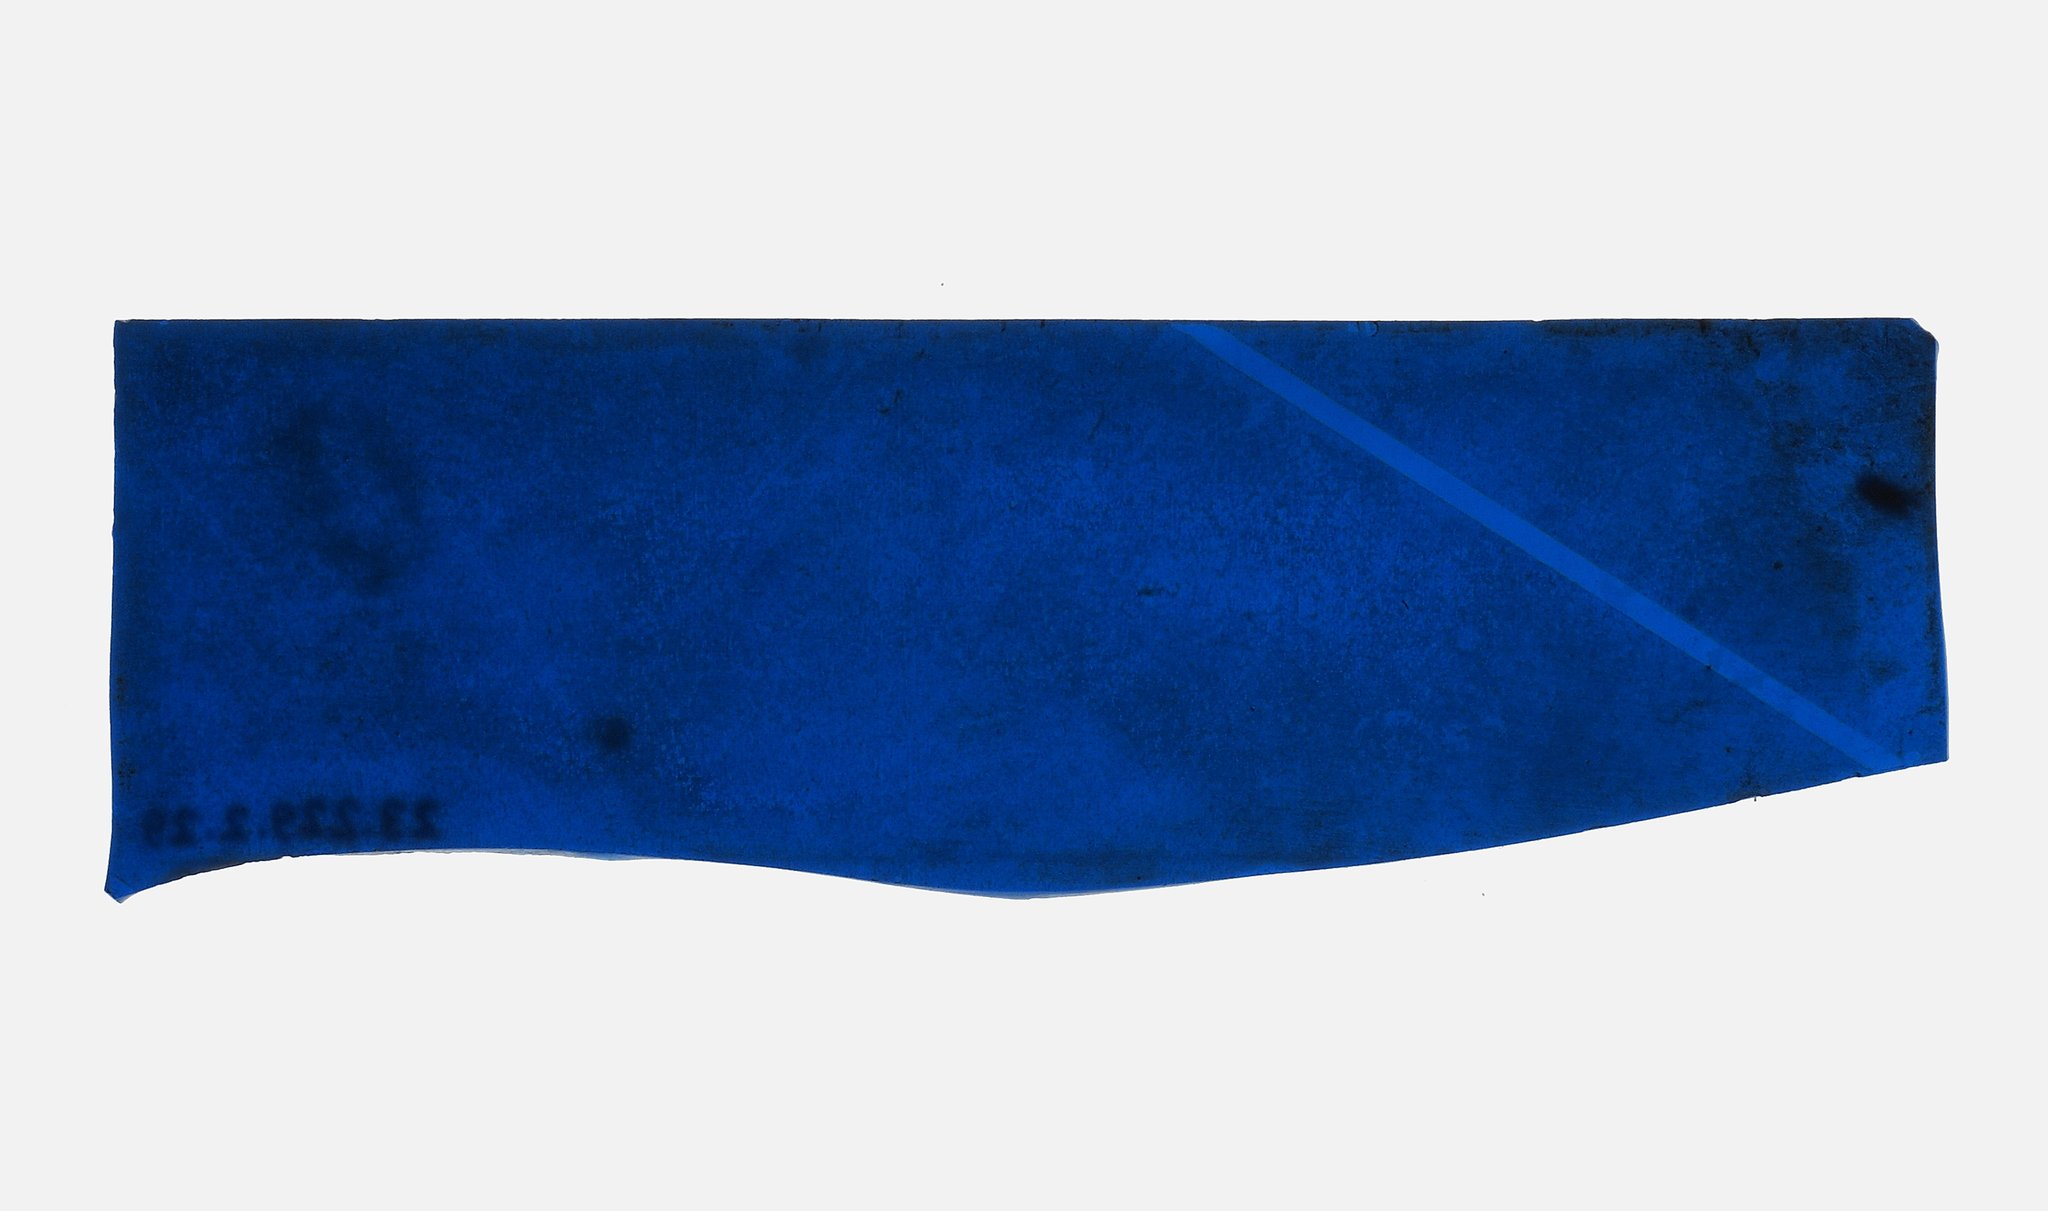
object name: fragment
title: Glass Fragment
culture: south netherlandish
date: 1601-1700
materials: glass, metal